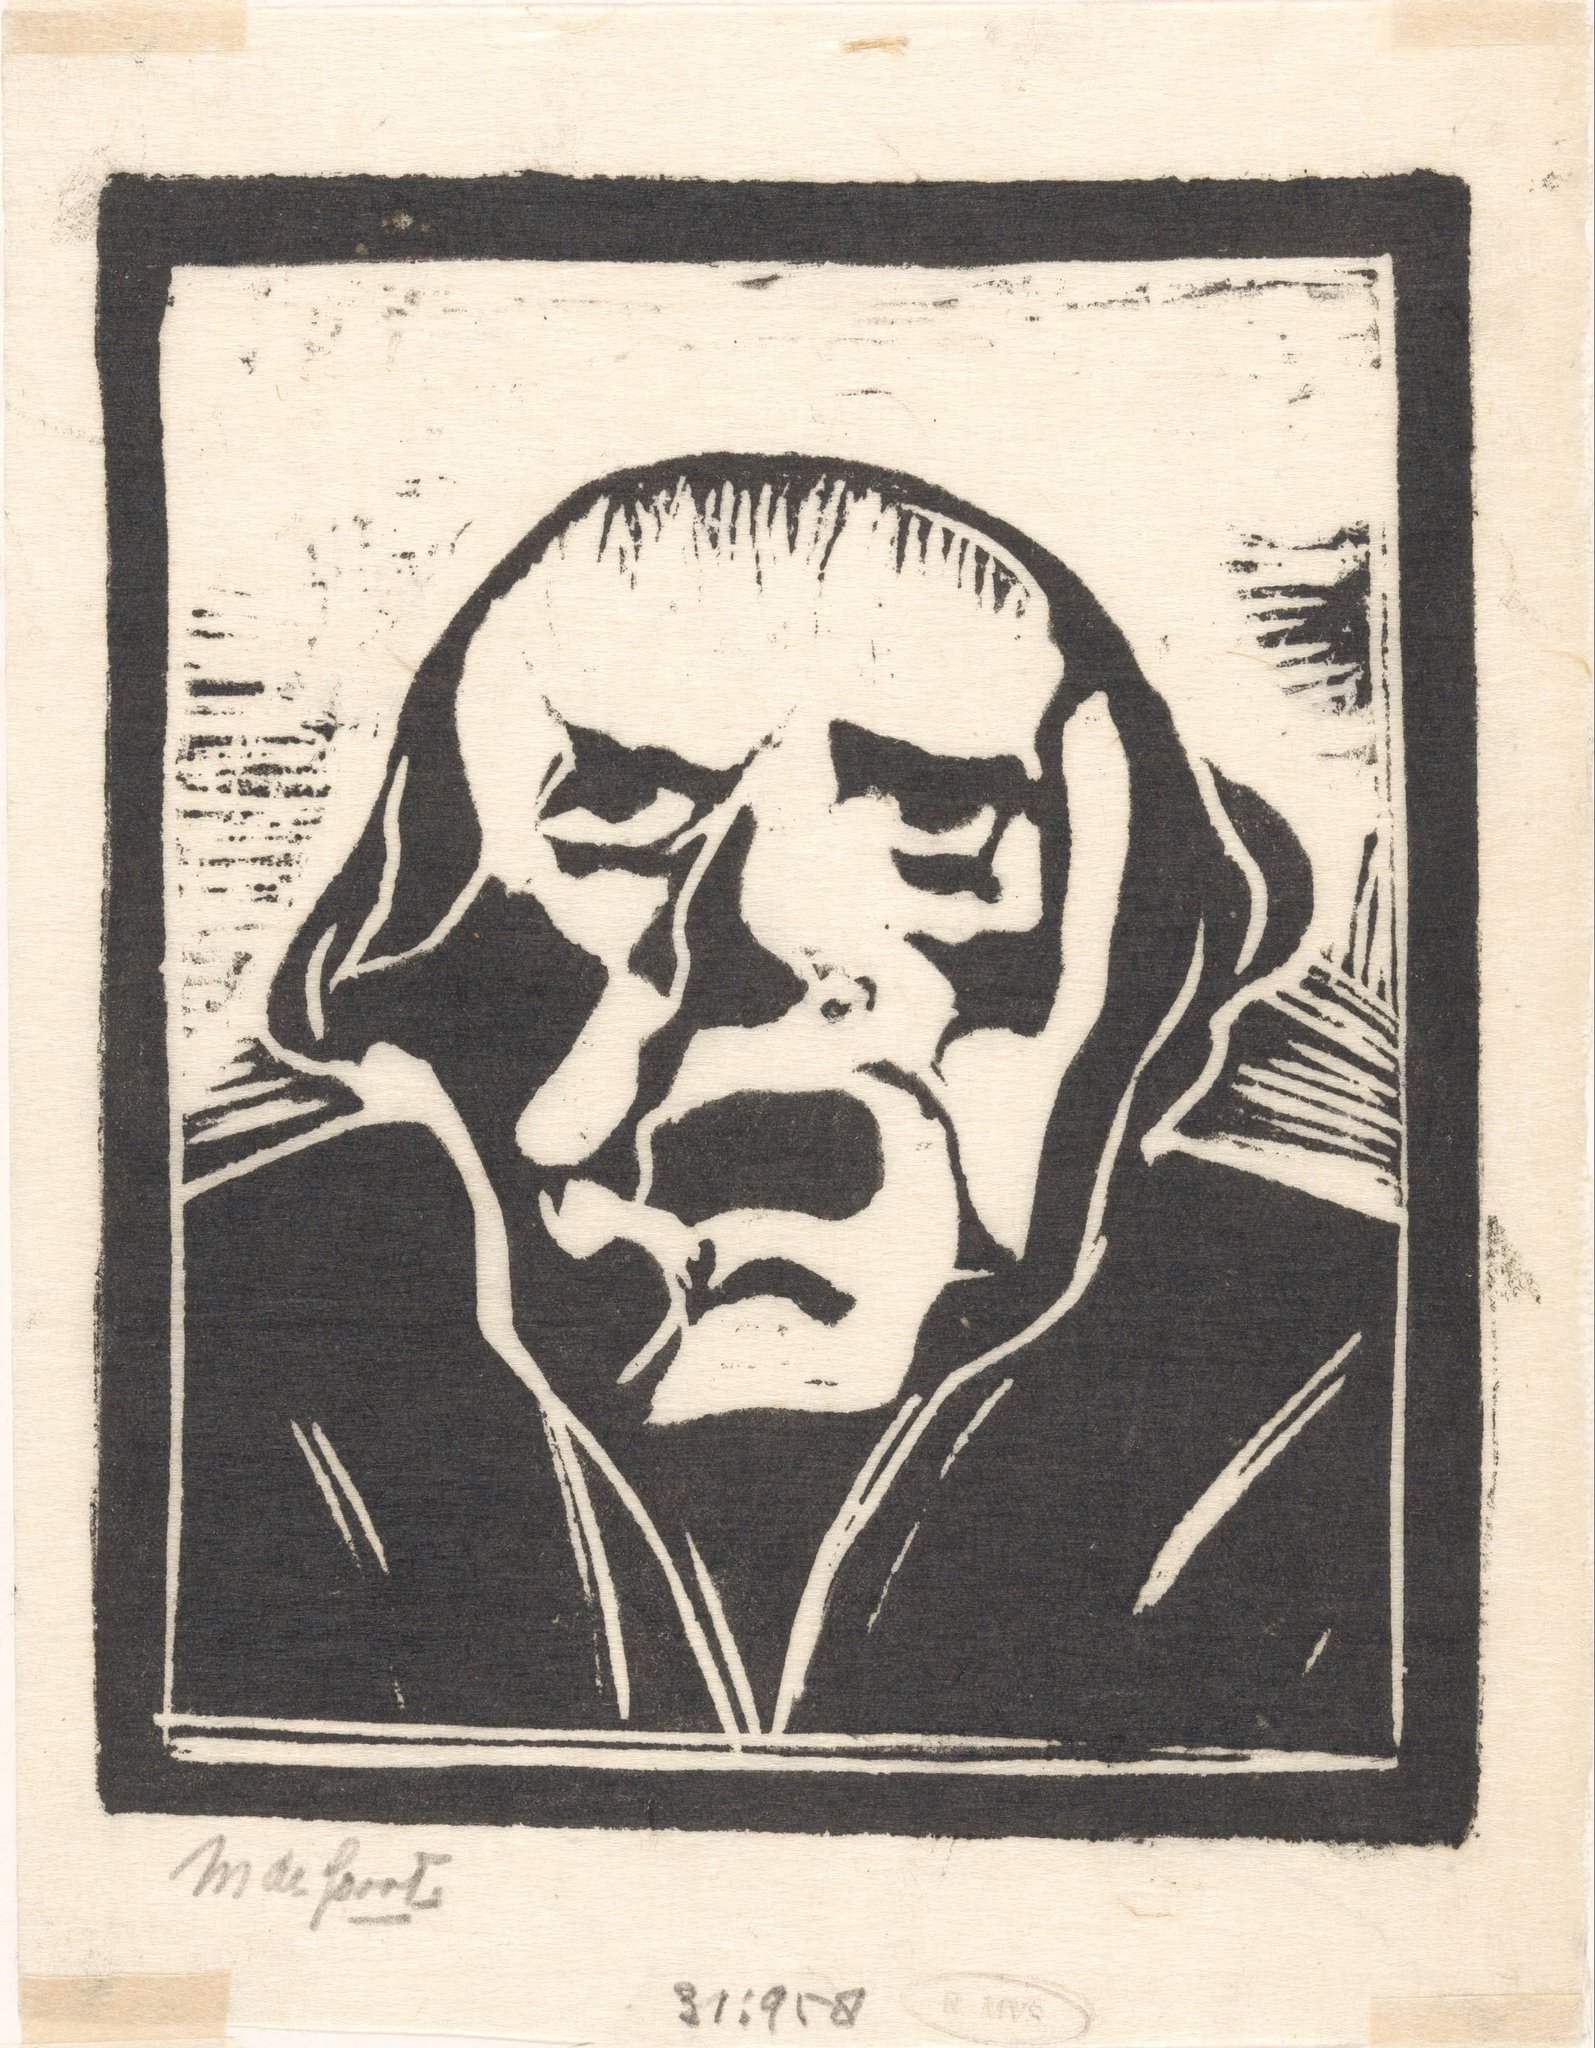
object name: print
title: Figuur met geopende mond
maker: maurits de groot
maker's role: print maker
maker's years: 1880-1934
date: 1890-1931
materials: paper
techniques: woodcut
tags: mouth wide open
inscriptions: collector's mark: Lugt 2228